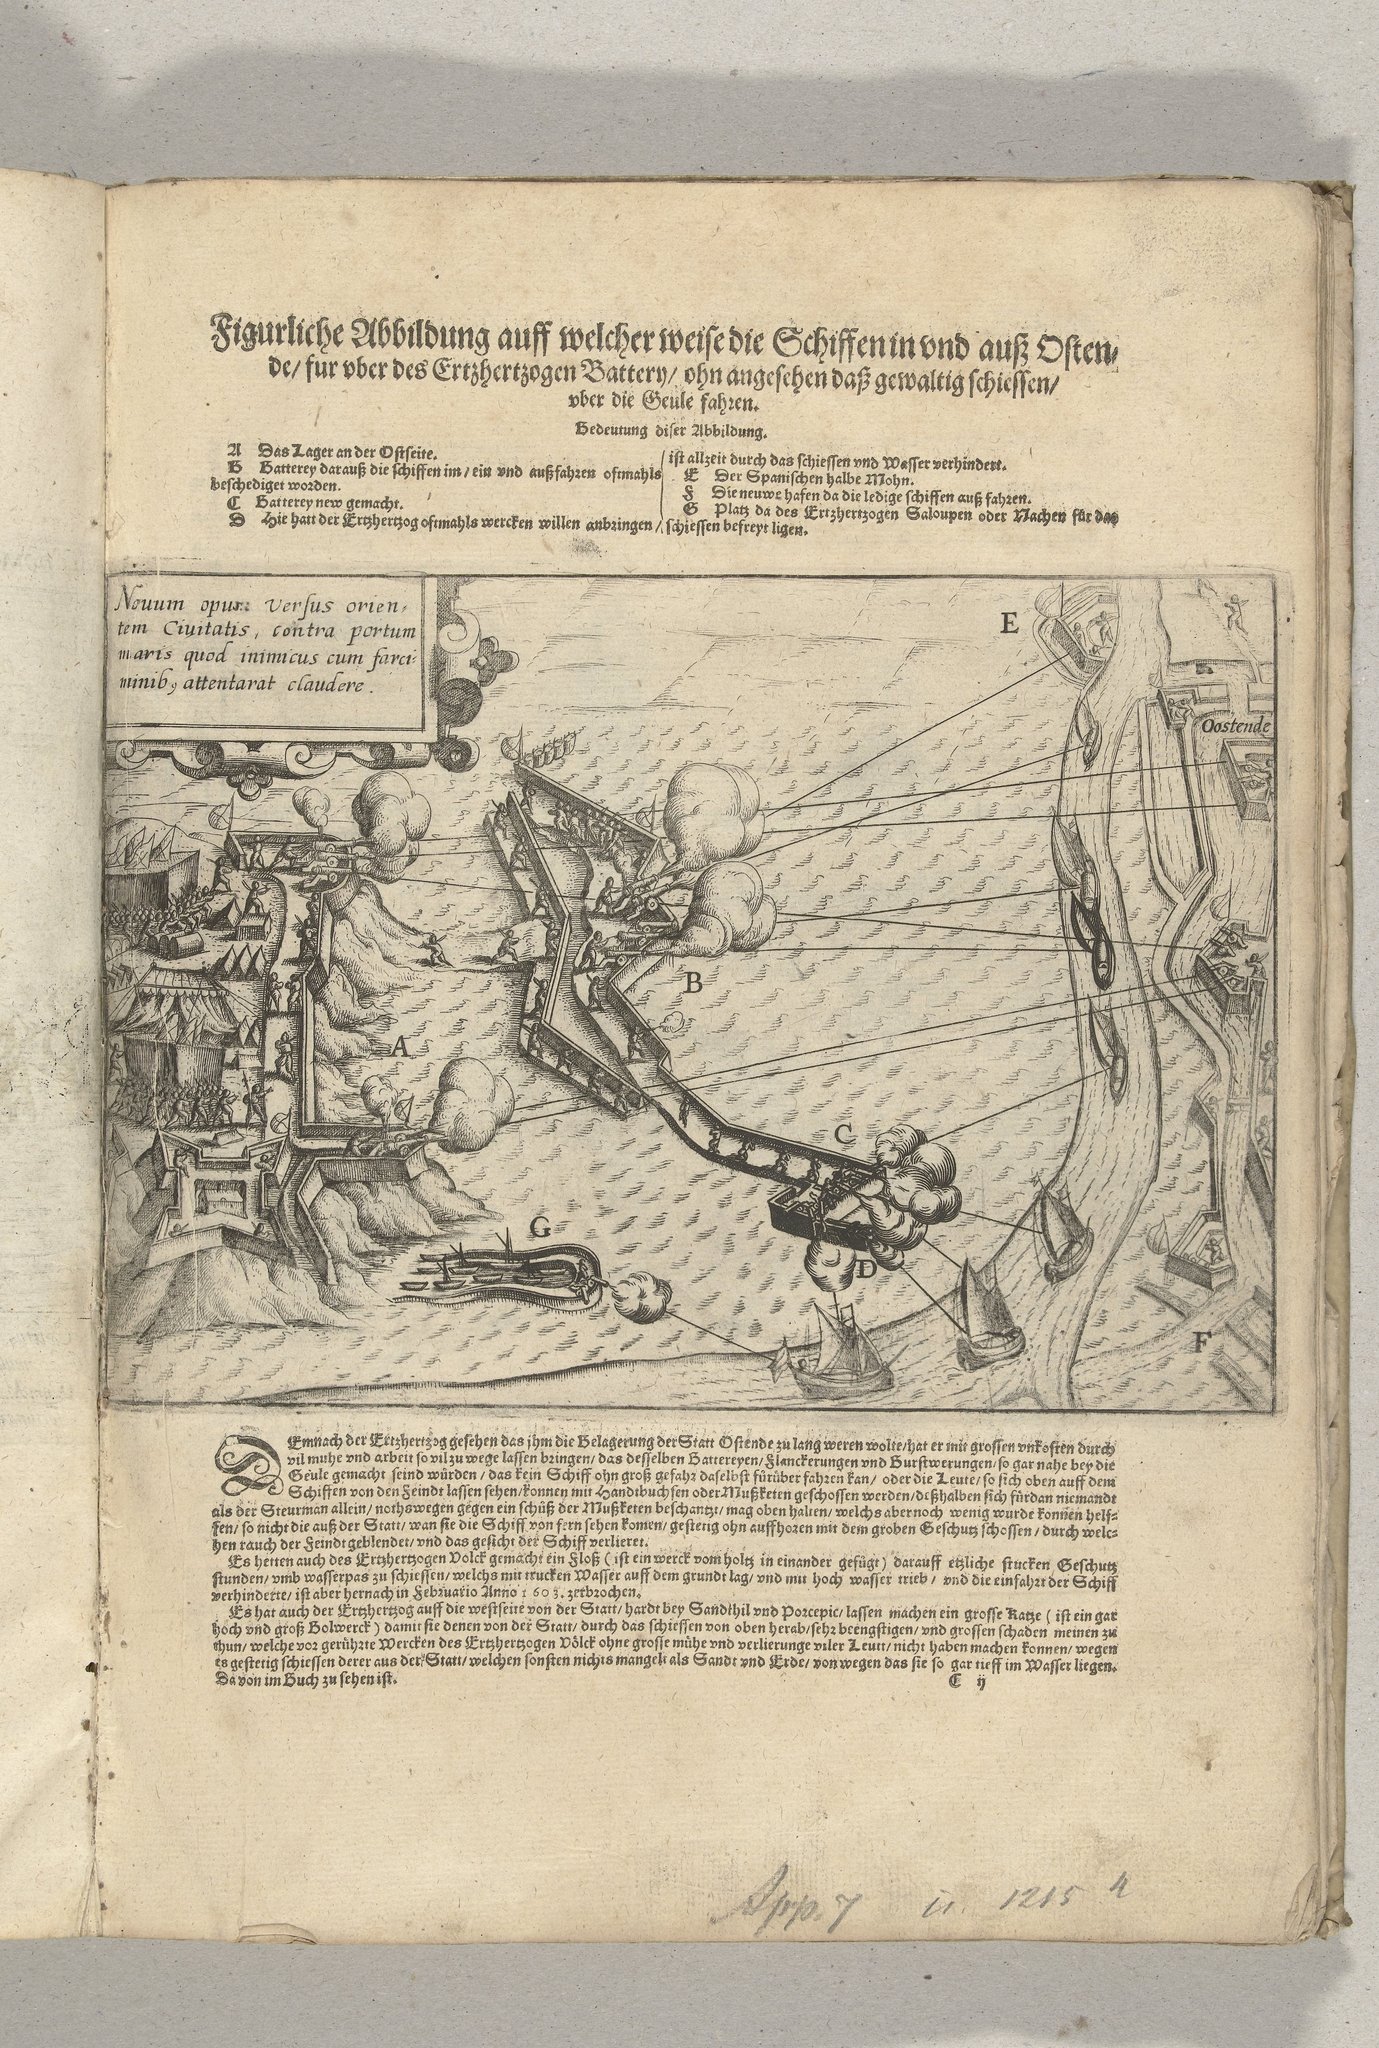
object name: print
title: Beleg van Oostende: beschieting van de schepen die de stad bevoorraden, 1603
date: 1603-1604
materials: paper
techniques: etching, letterpress printing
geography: low countries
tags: siege, position war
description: Onderdeel van illustraties in: Belaegerung der Statt Ostende : Journal: Tagregister... aller gedenckwurdigsten Sachen... so inner und ausserhalb... sich zugetragen... von 5 July 1601. biss auff diese.. Herbstmisse Anno 1604... auss der Niderlendischen in die Hochteutsche Sprach transferirt, Und mit: Journal. Ander theil uber die Belägerung der statt Ostende biss auf die Herbstmiss in Sept. 1604 bey gefugt Mappa der Statt Ostende neben dem abriss des Parvae und Novae Troiae, s.l., 1604, fol°, ill. Hierbij gevoegd enkele prenten voorzien van Duitse teksten, 1604 (z.n., z.p.). In het exemplaar in de collectie van de Rijksmuseum Research Library (326 F 10).